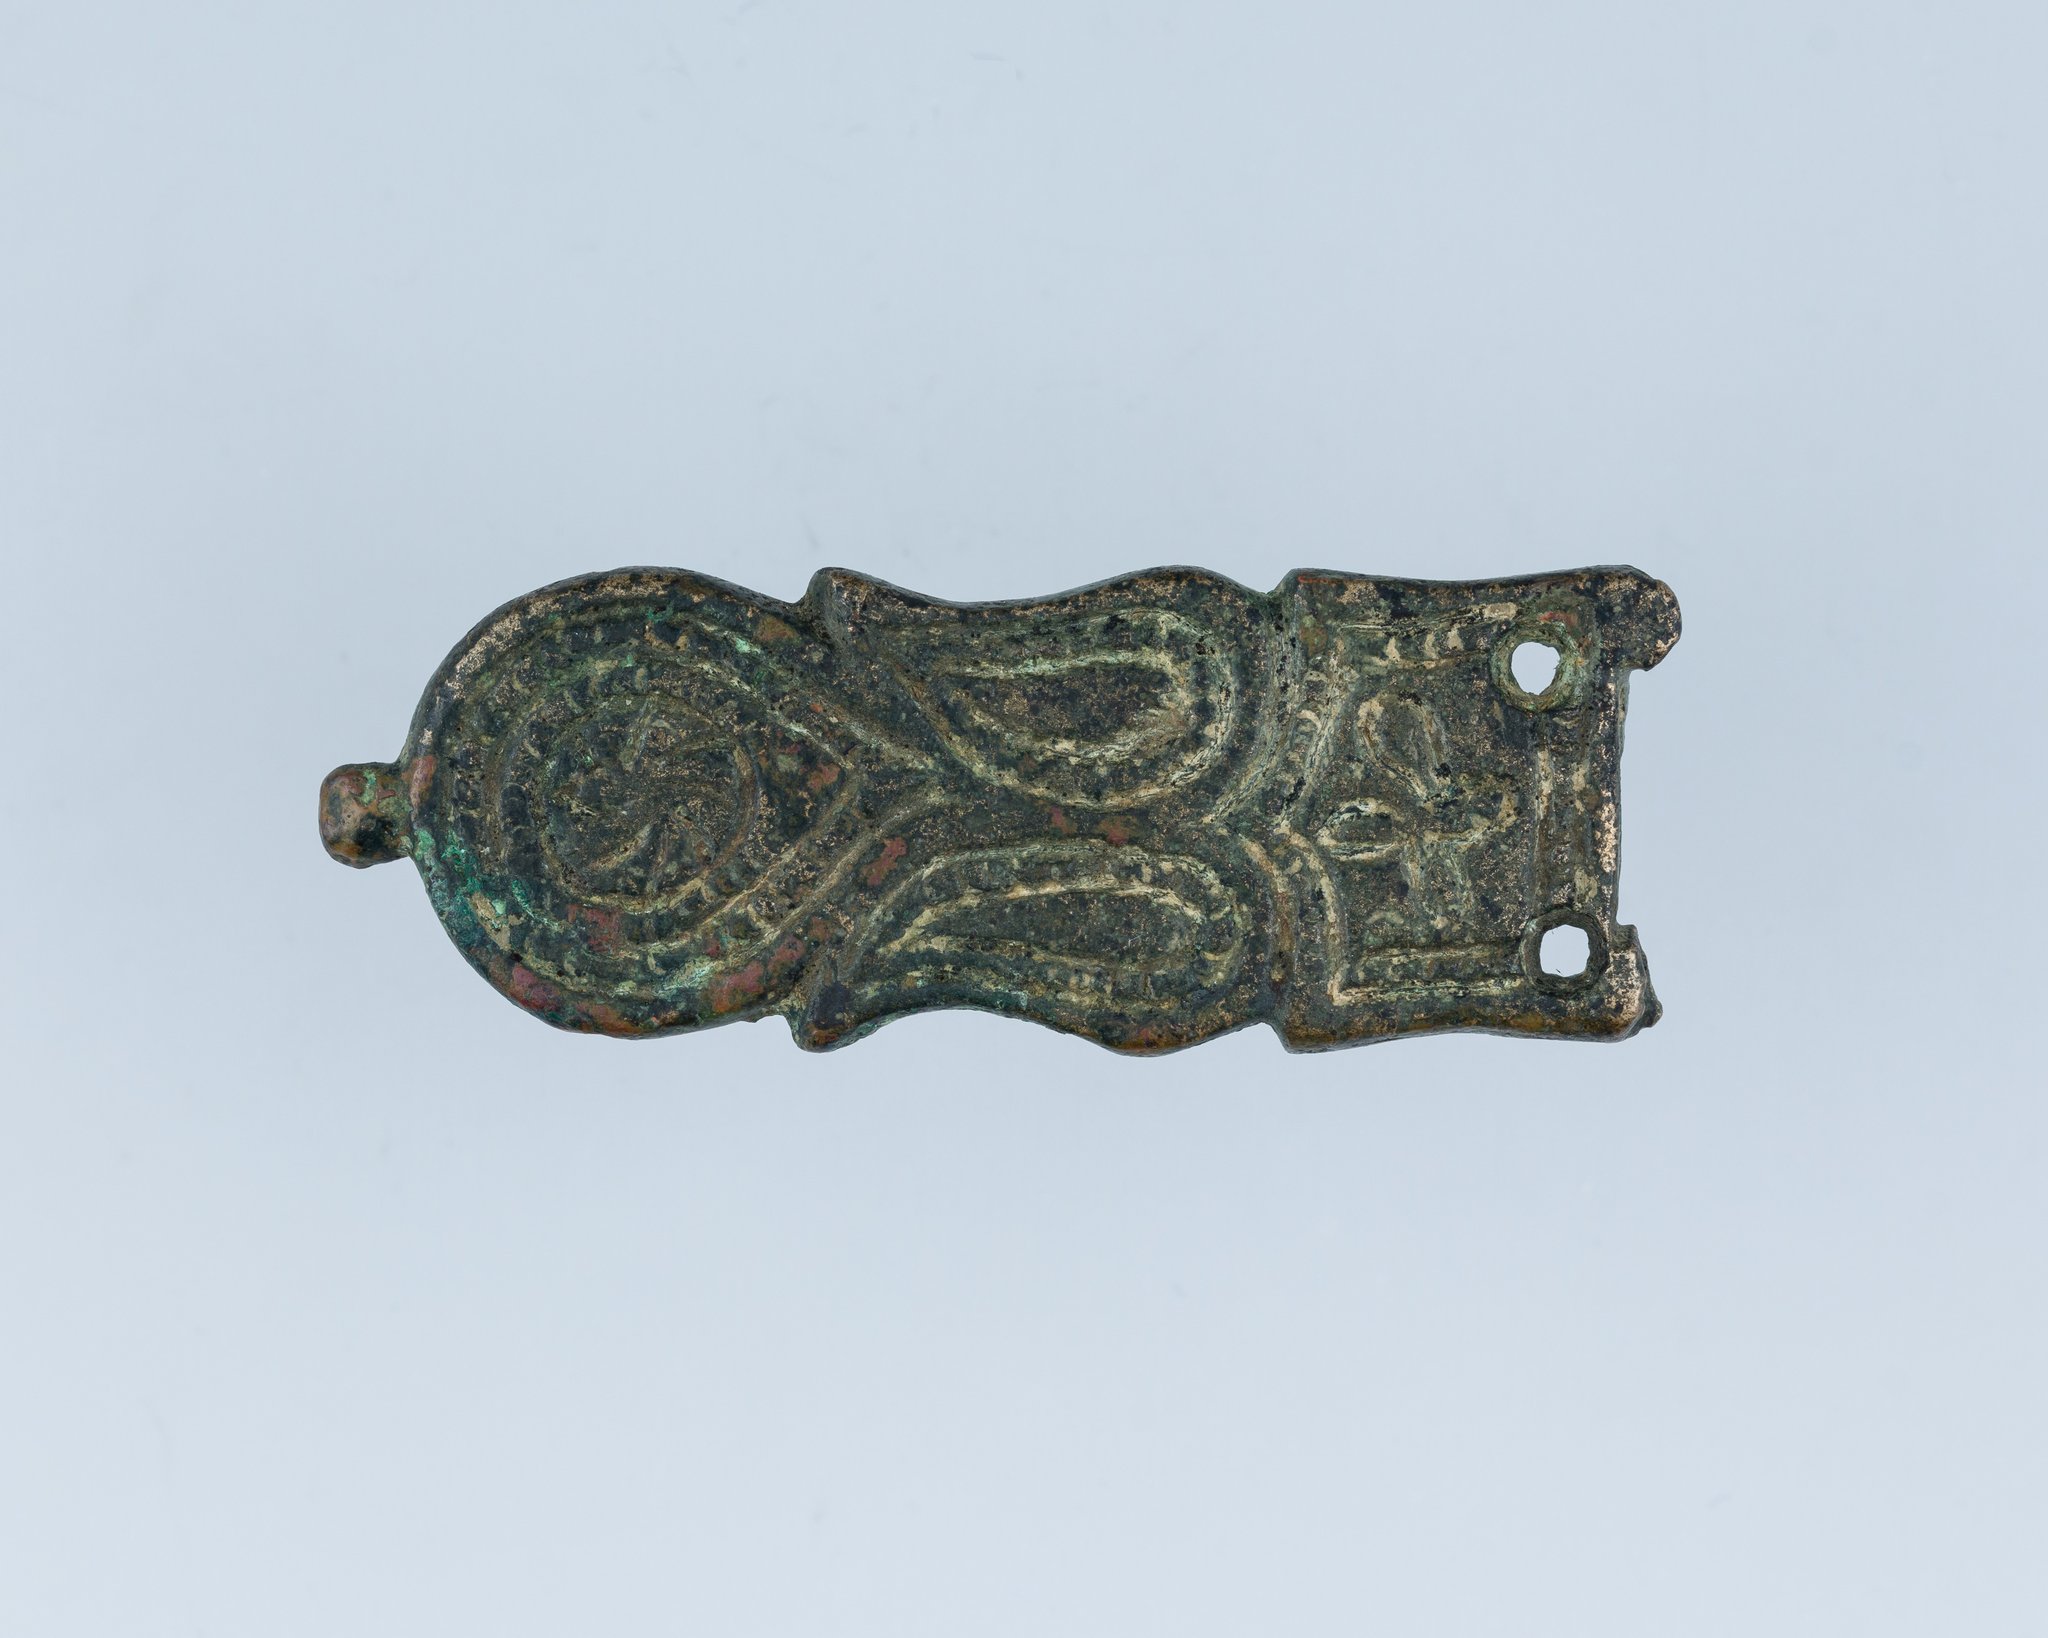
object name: buckle shank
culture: visigothic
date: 401-700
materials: bronze